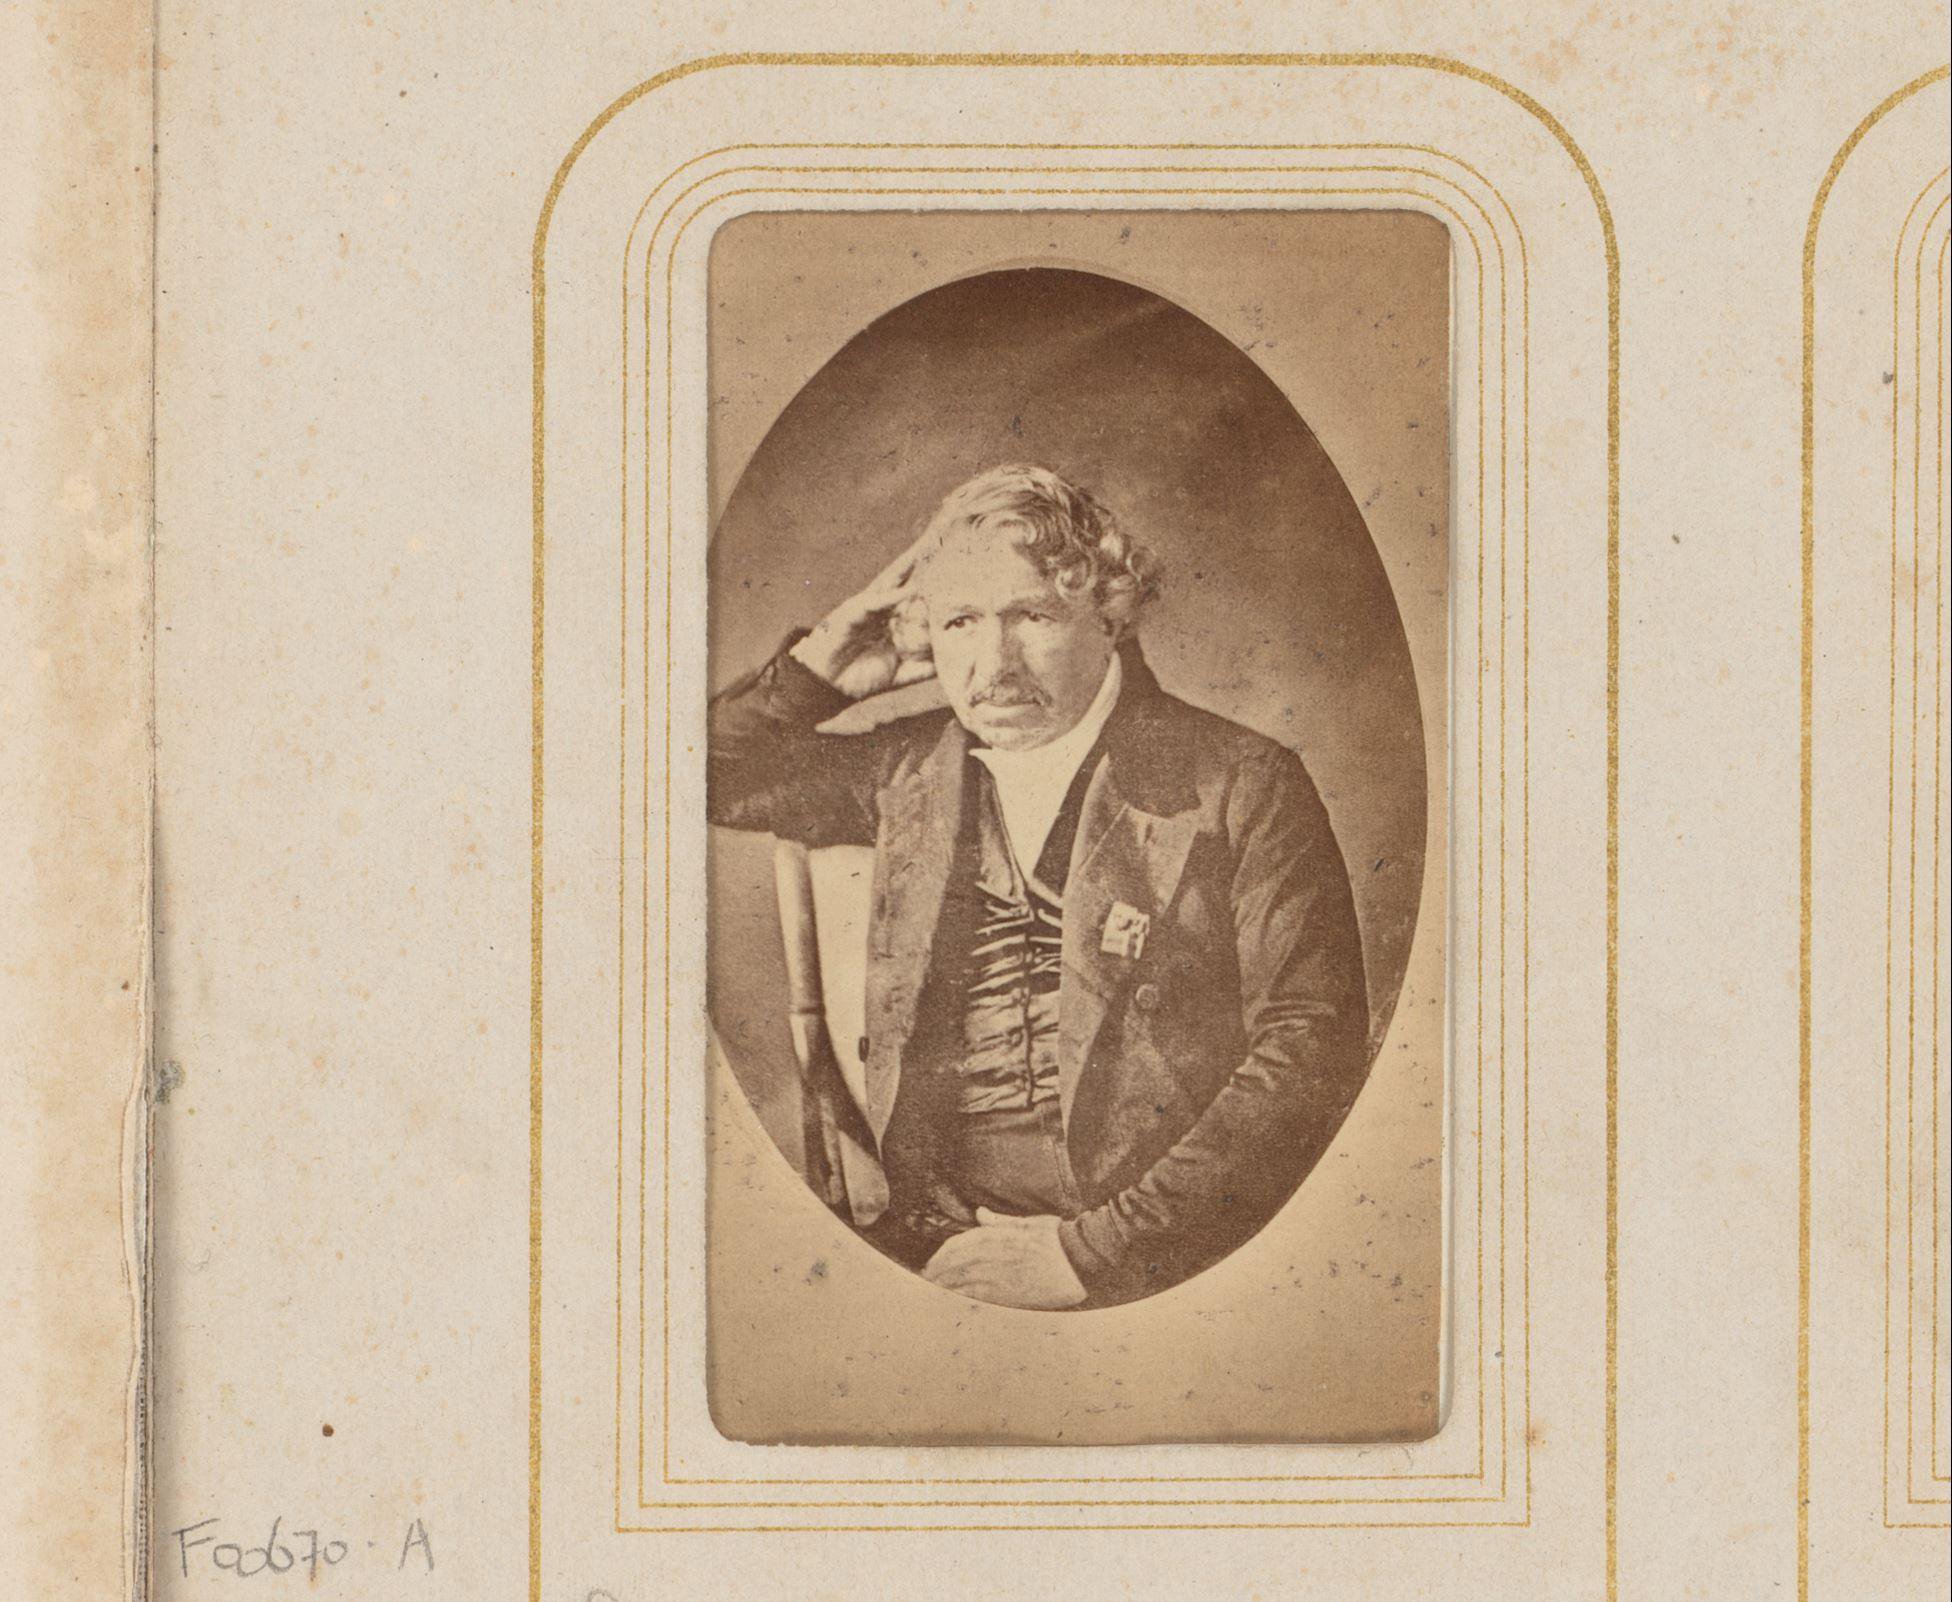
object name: carte de visite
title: Fotoreproductie van een portret van Louis Jacques Mandé Daguerre naar Mayer & Pierson door Plant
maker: paul emile pesme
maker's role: fotograaf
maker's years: 1826-1877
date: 1850-1860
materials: cardboard, photographic support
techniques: albumen print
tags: louis jacques mandé daguerre, historical persons, portrait, self-portrait of photographer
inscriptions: inscription: ‘Collé-vérane/ Rue st. Ferreol, 14, Marseille./ Paris’, annotation: ‘Louis Jaques Mandé Daguerre/ 1789 - 1851’, name: ‘Daguerre’